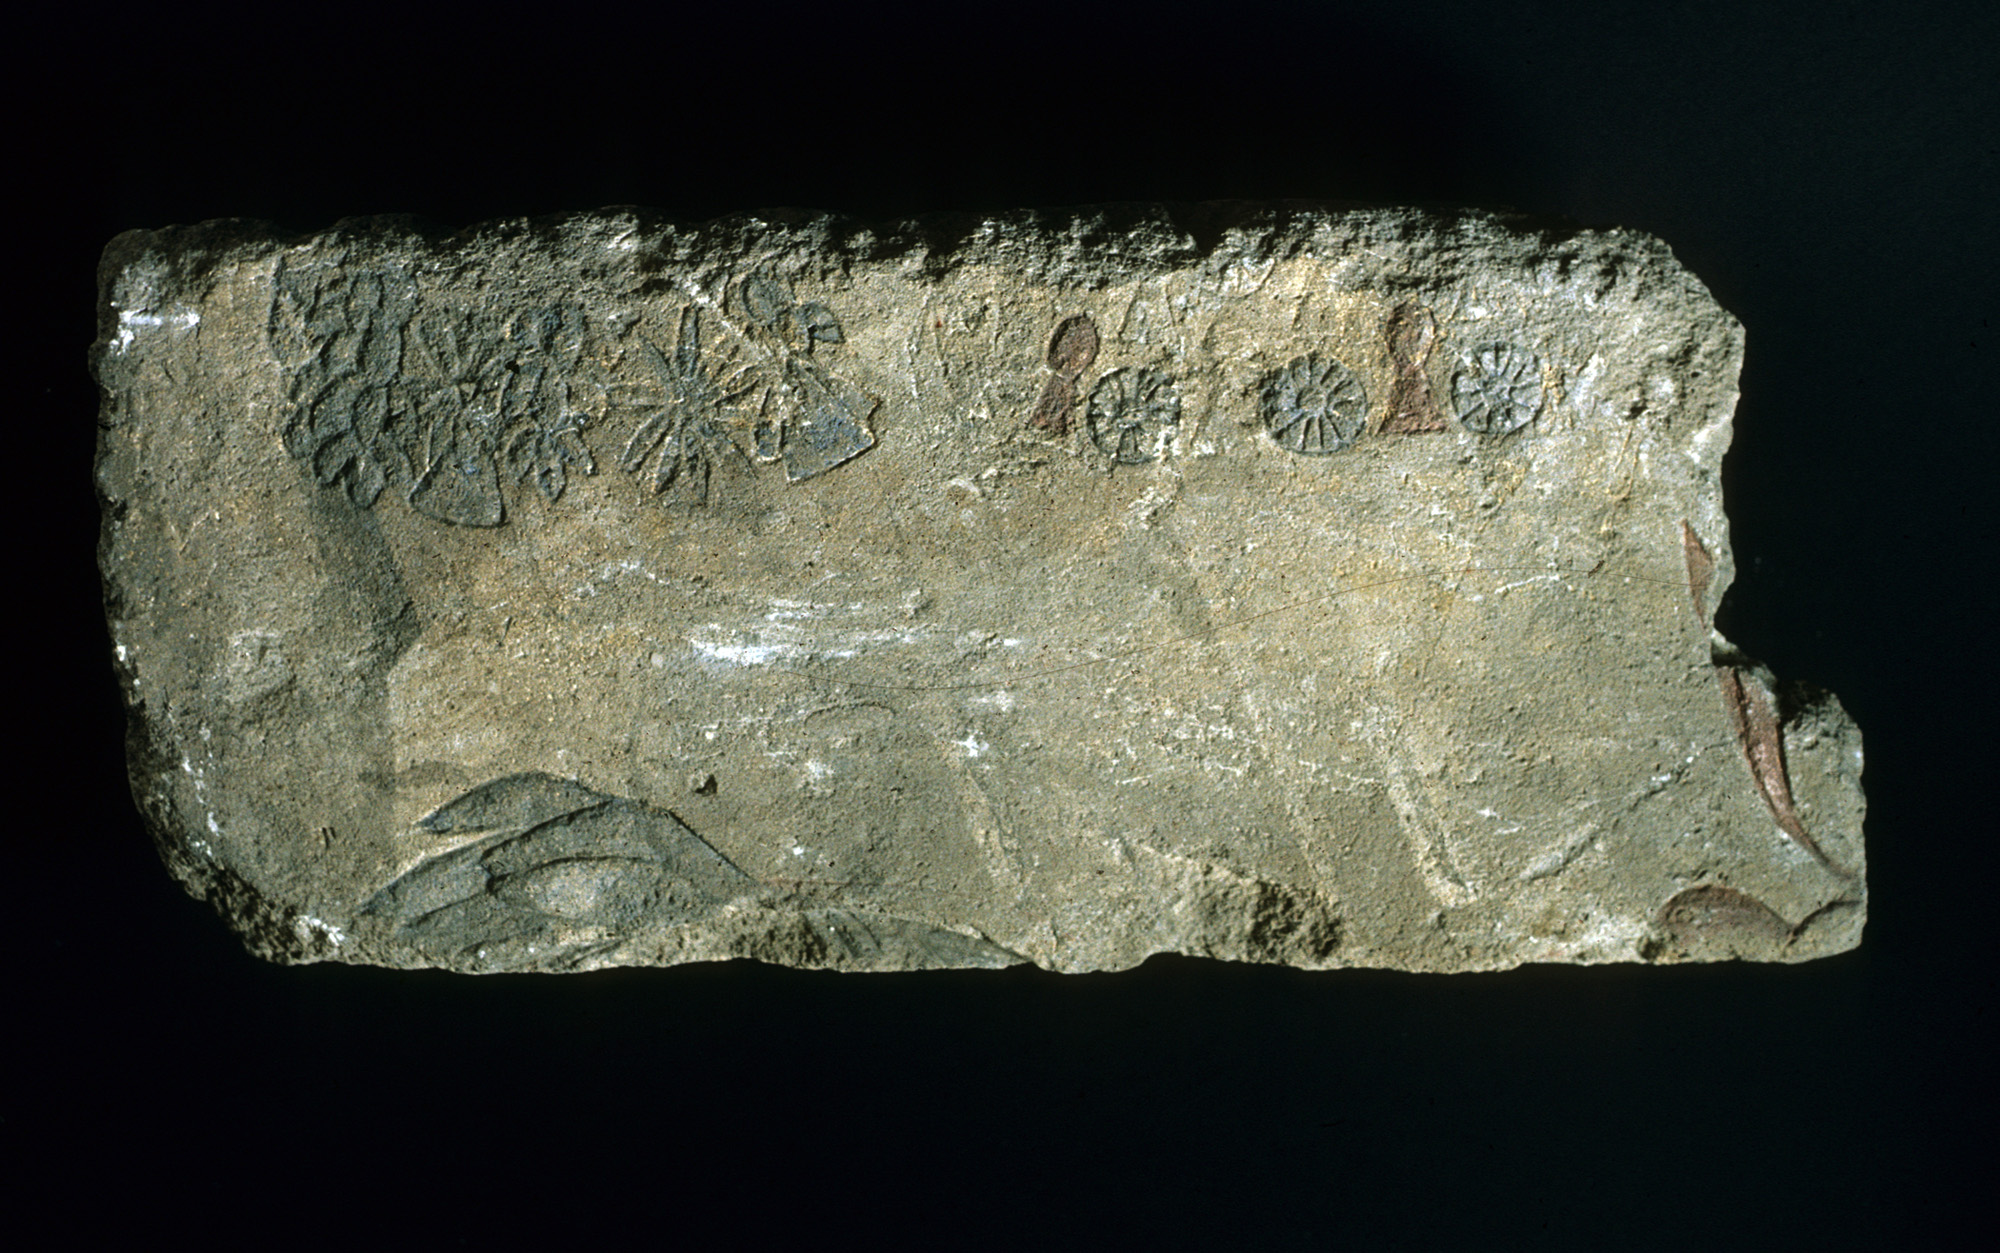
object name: talatat, kiosk interior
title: Relief of kiosk interior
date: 1353-1336 BCE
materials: limestone, paint